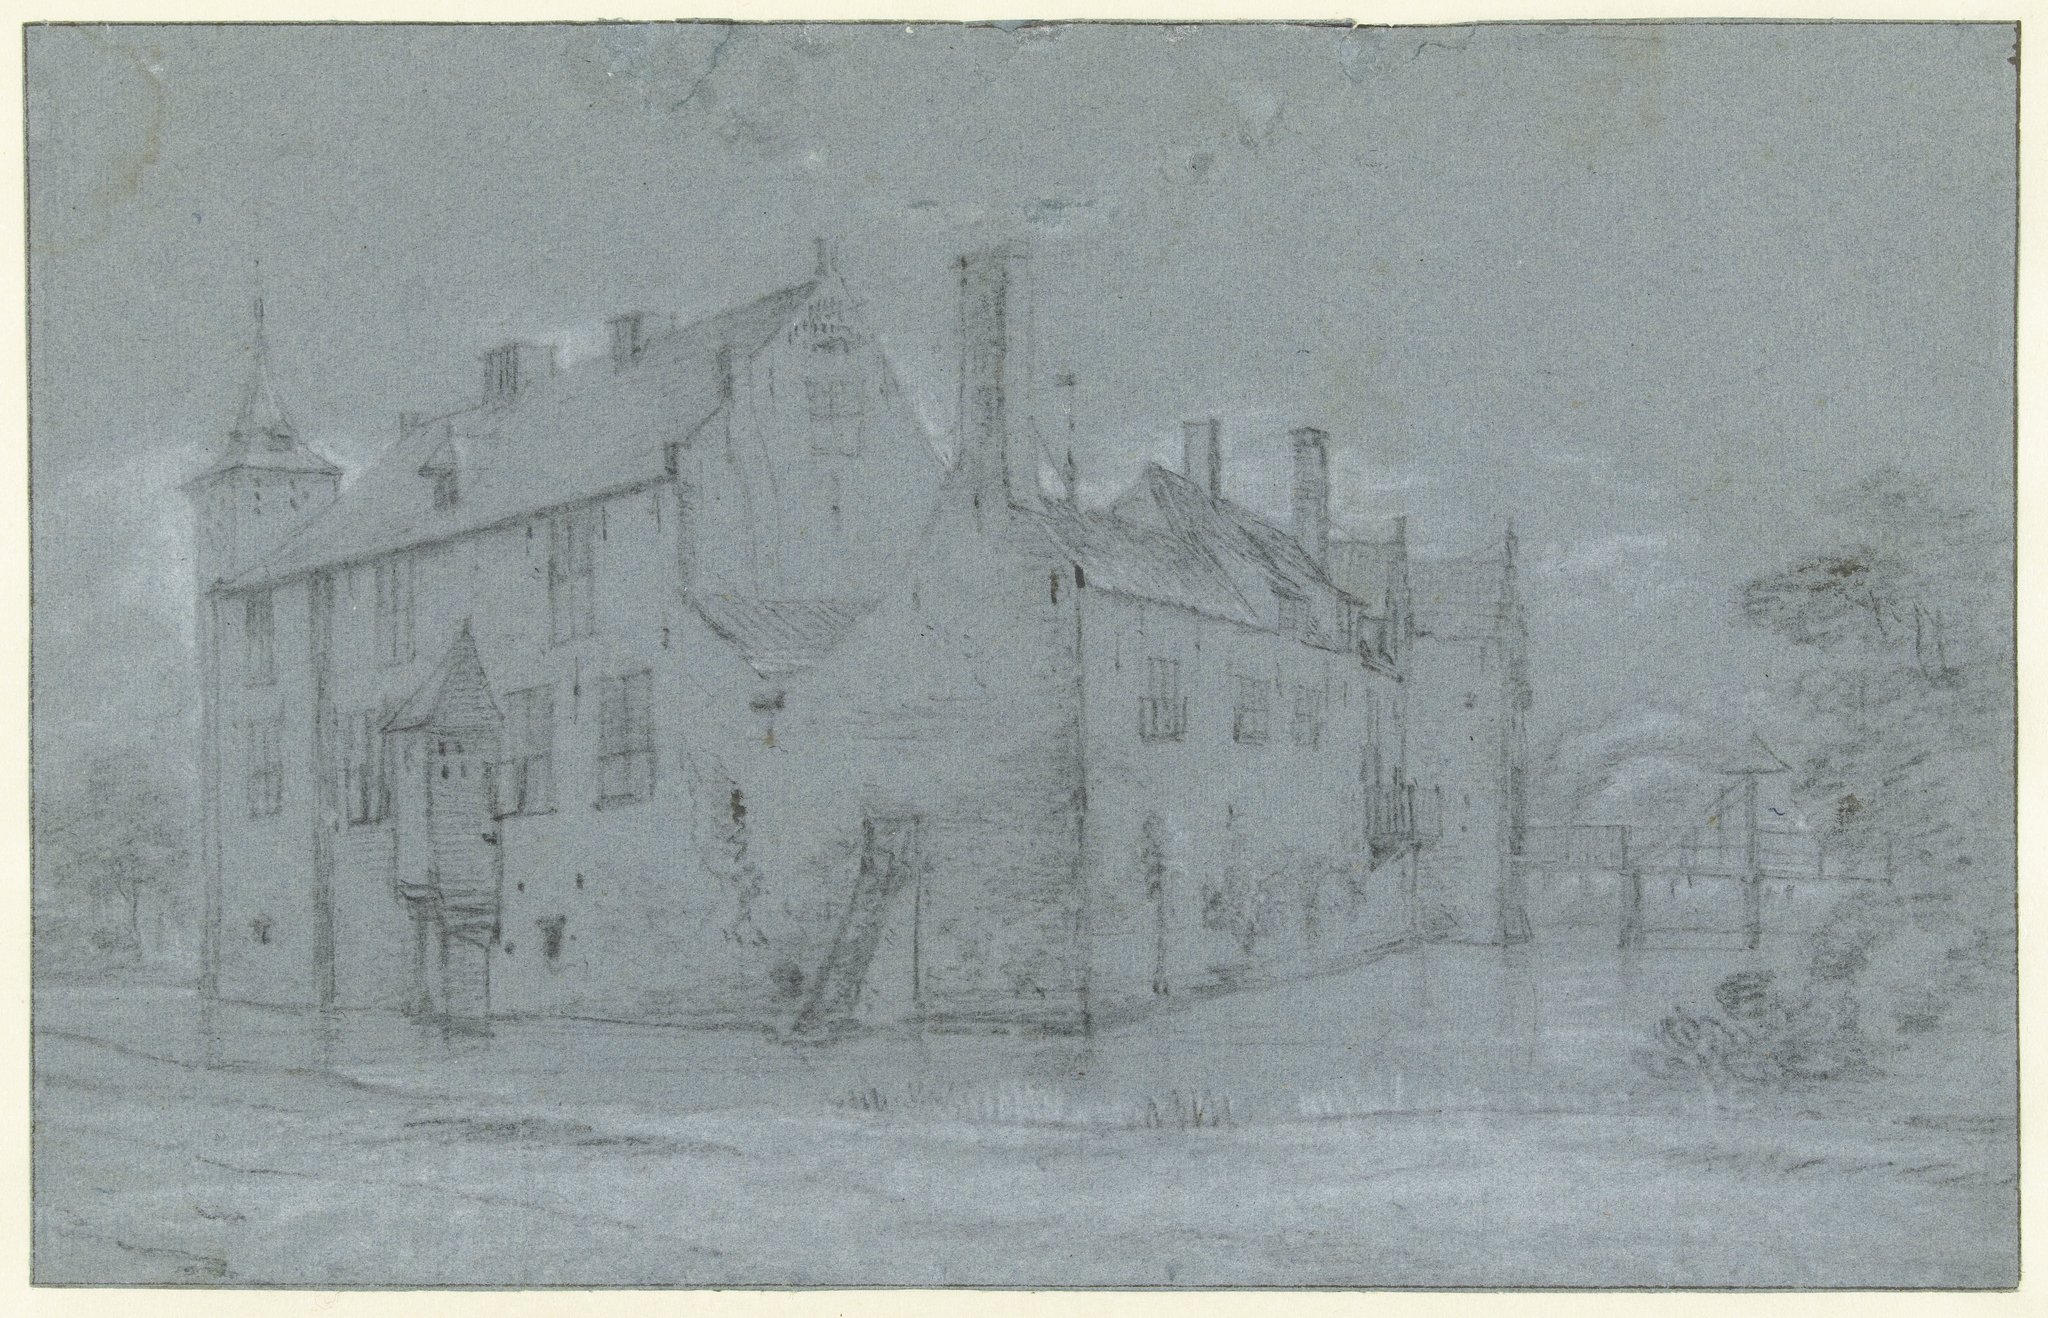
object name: drawing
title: View of Kasteel Oud-Heusden (also known as Nieuwenroy)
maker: roelant roghman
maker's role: draughtsman, painter, print maker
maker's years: 1627-1692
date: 1646-1647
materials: chalk, ink, paper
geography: kasteel oudheusden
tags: castle, kasteel oudheusden